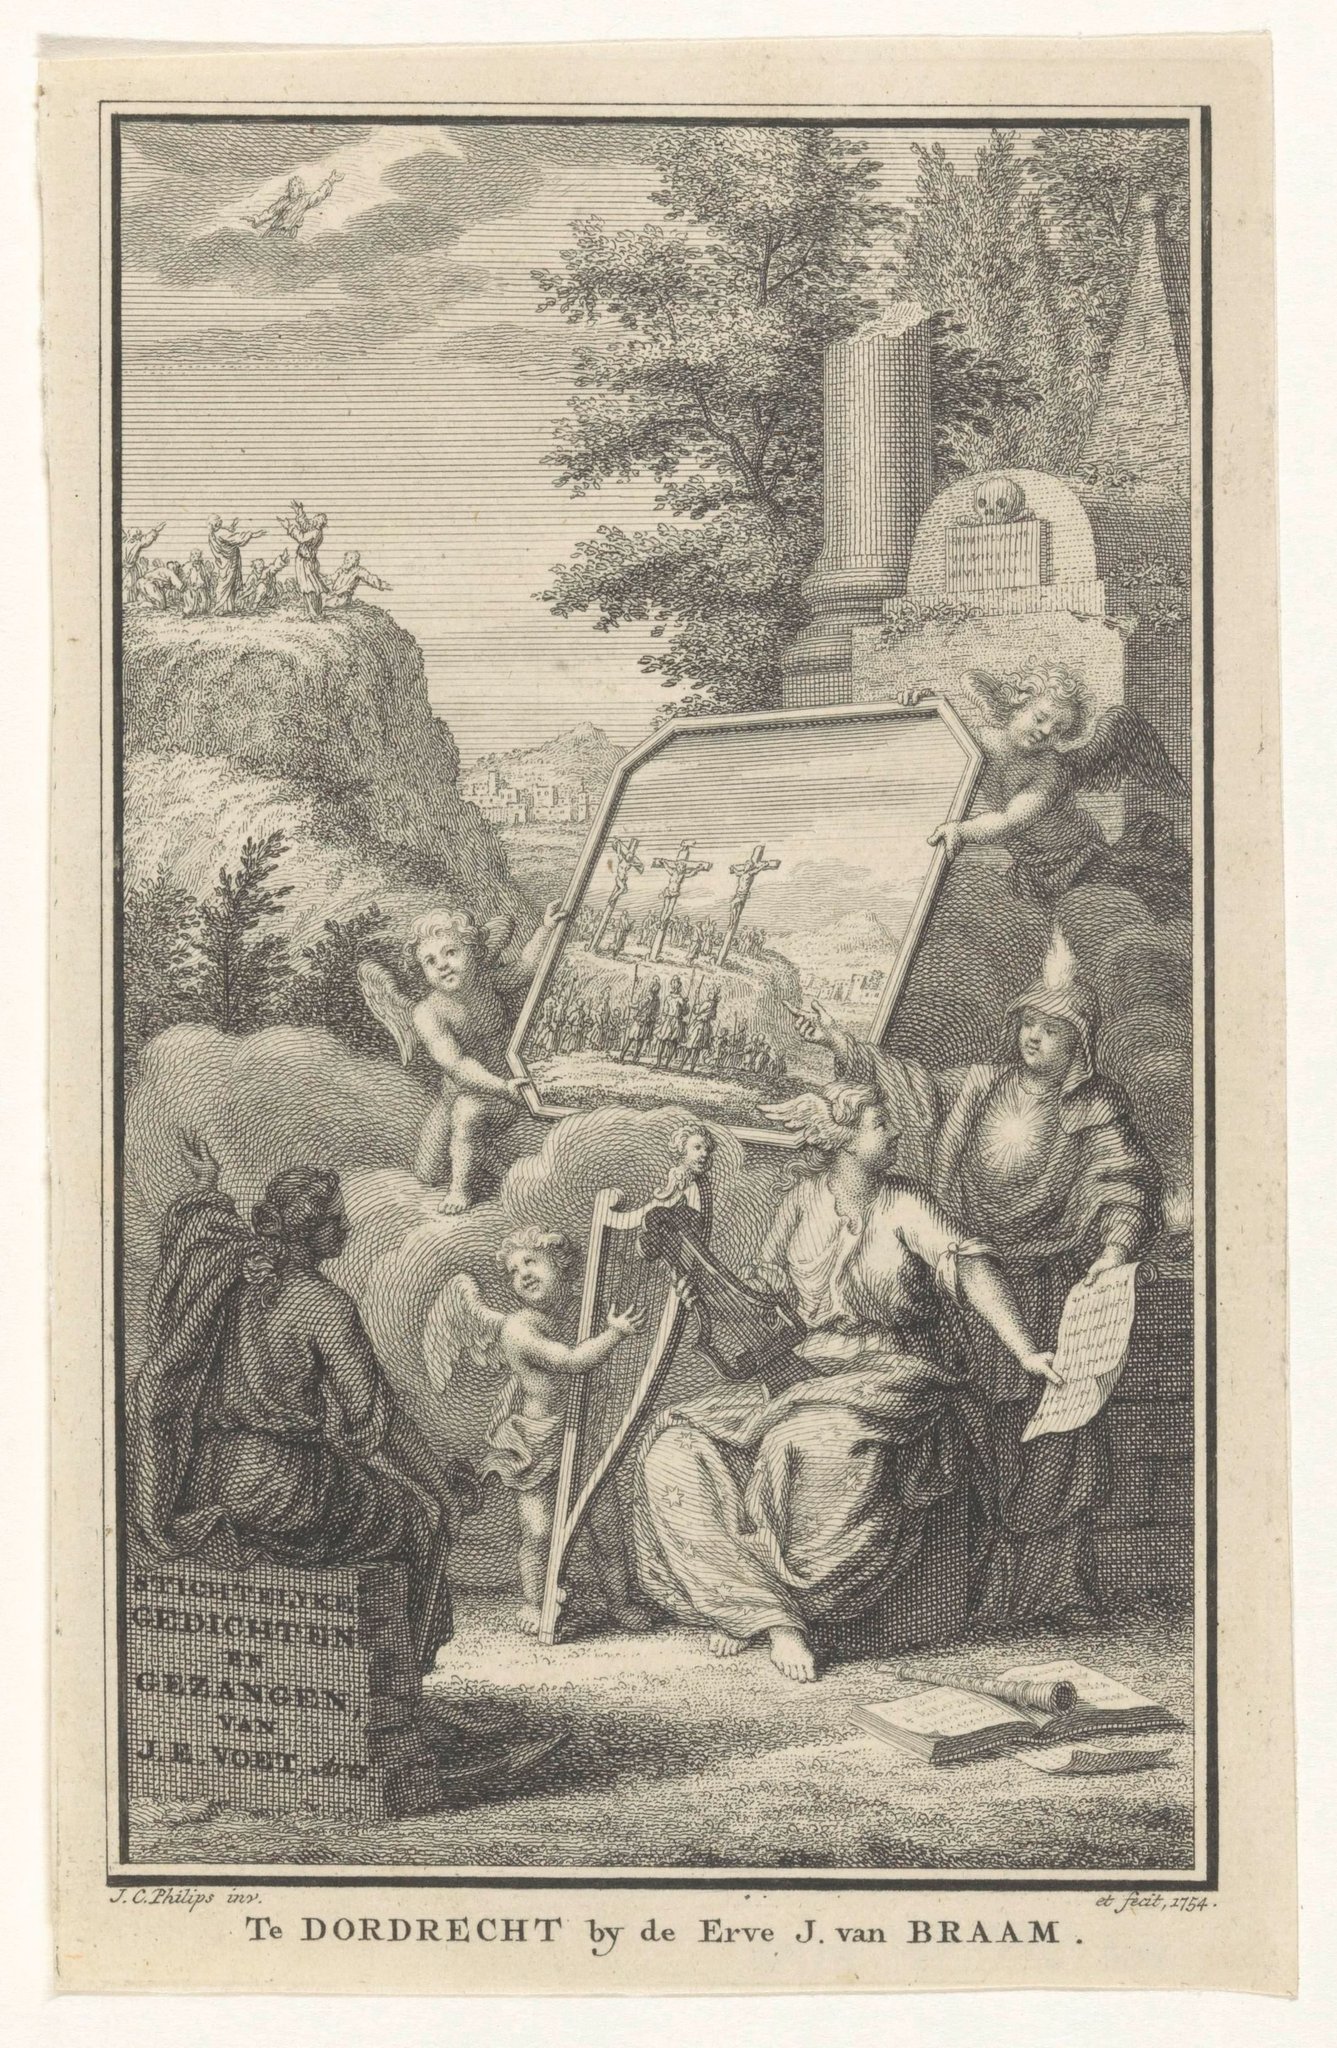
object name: print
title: Titelpagina voor: Johannes Euseubius Voet, Stichtelyke gedichten en gezangen, 1754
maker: jan caspar philips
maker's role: draughtsman, print maker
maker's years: 1700-1775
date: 1754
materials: paper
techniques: engraving, etching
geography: dordrecht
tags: faith, 'fides'; 'fede', 'fede catholica', 'fede christiana', 'fede christiana catholica' (ripa) ~ one of the three theological virtues, hope, 'spes'; 'speranza divina e certa' (ripa) ~ one of the three theological virtues, lyre, cithara, psaltery, the crucifixion of christ: christ's death on the cross; golgotha (matthew 27:45-58; mark 15:33-45; luke 23:44-52; john 19:25-38)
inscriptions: collector's mark: Lugt 2228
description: Titelpagina voor: Voet, Johannes Euseubius. Stichtelyke gedichten en gezangen. Dordrecht: Braam, erven Joannes van, 1755. Prent afkomstig uit een plakalbum met titelprenten, ornamenten etc. op blauw papier in 1983 uit elkaar gehaald. Volgens een notitie op verso zat de prent op p. 103 van dit album.